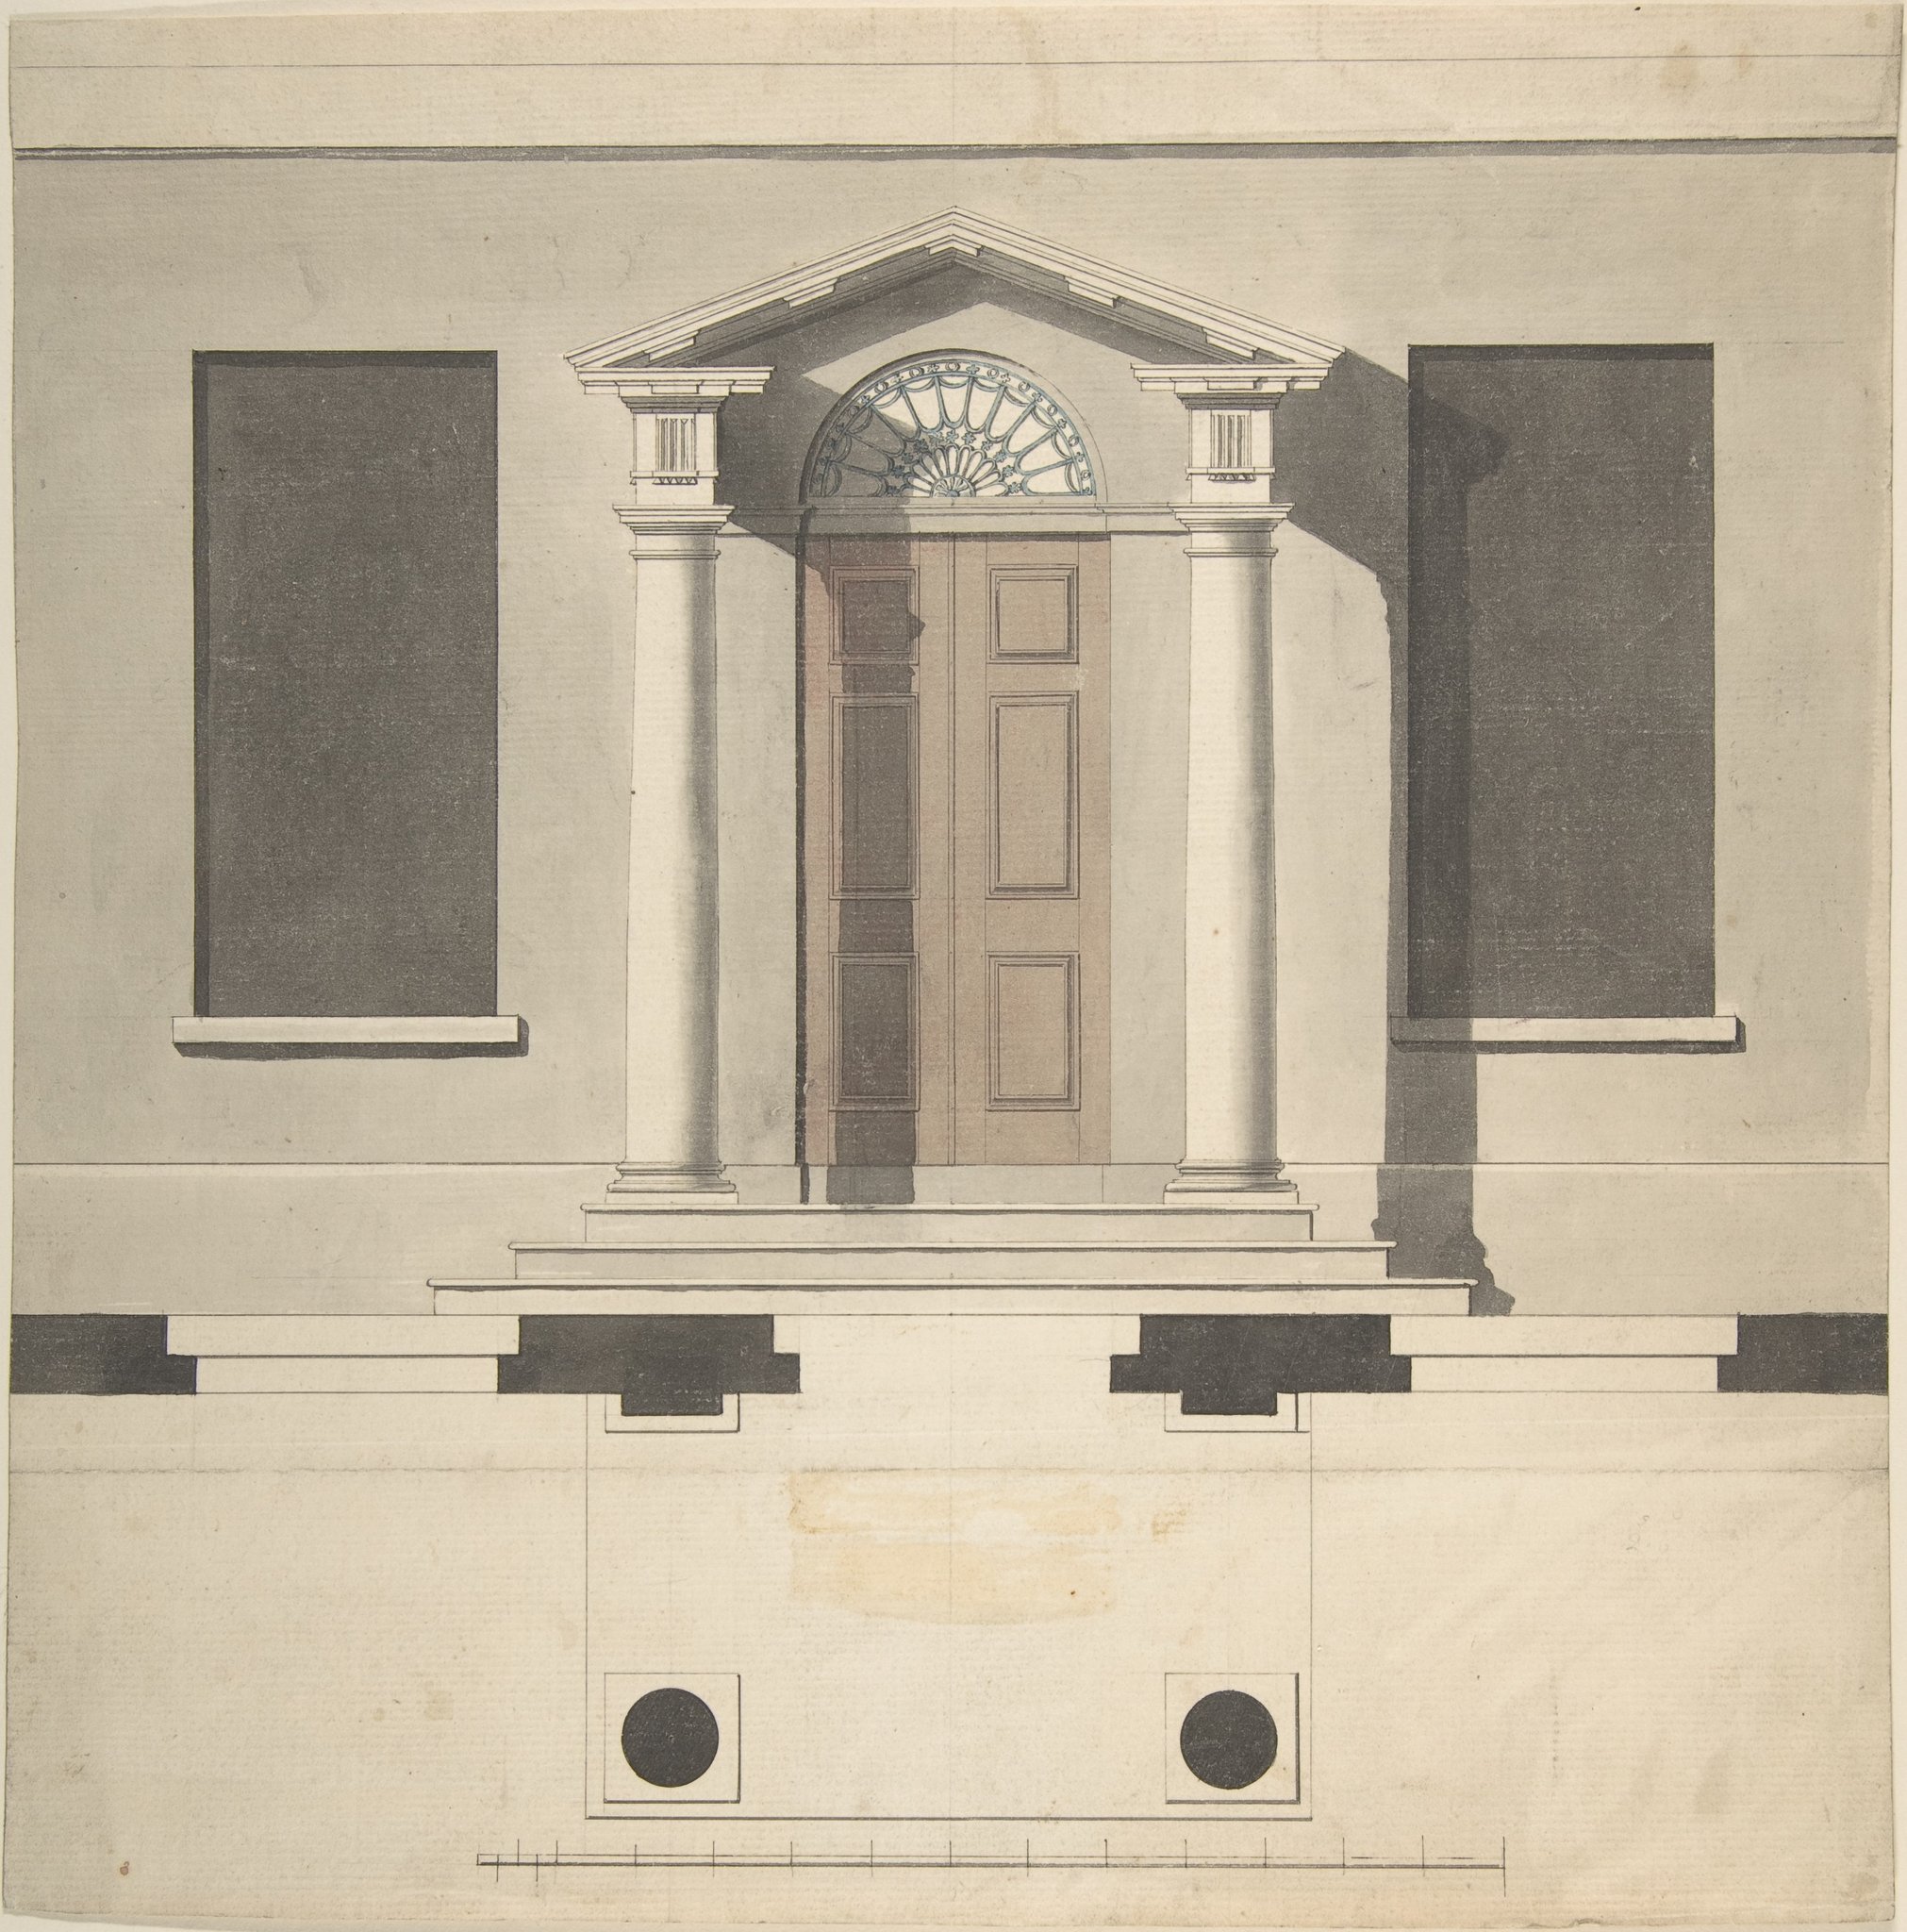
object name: drawing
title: Design for a Doric Porch, Plan and Elevation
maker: robert adam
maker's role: artist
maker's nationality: british, scottish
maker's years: 1728-1792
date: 1751-1800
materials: ink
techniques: brush, pen, wash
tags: architecture